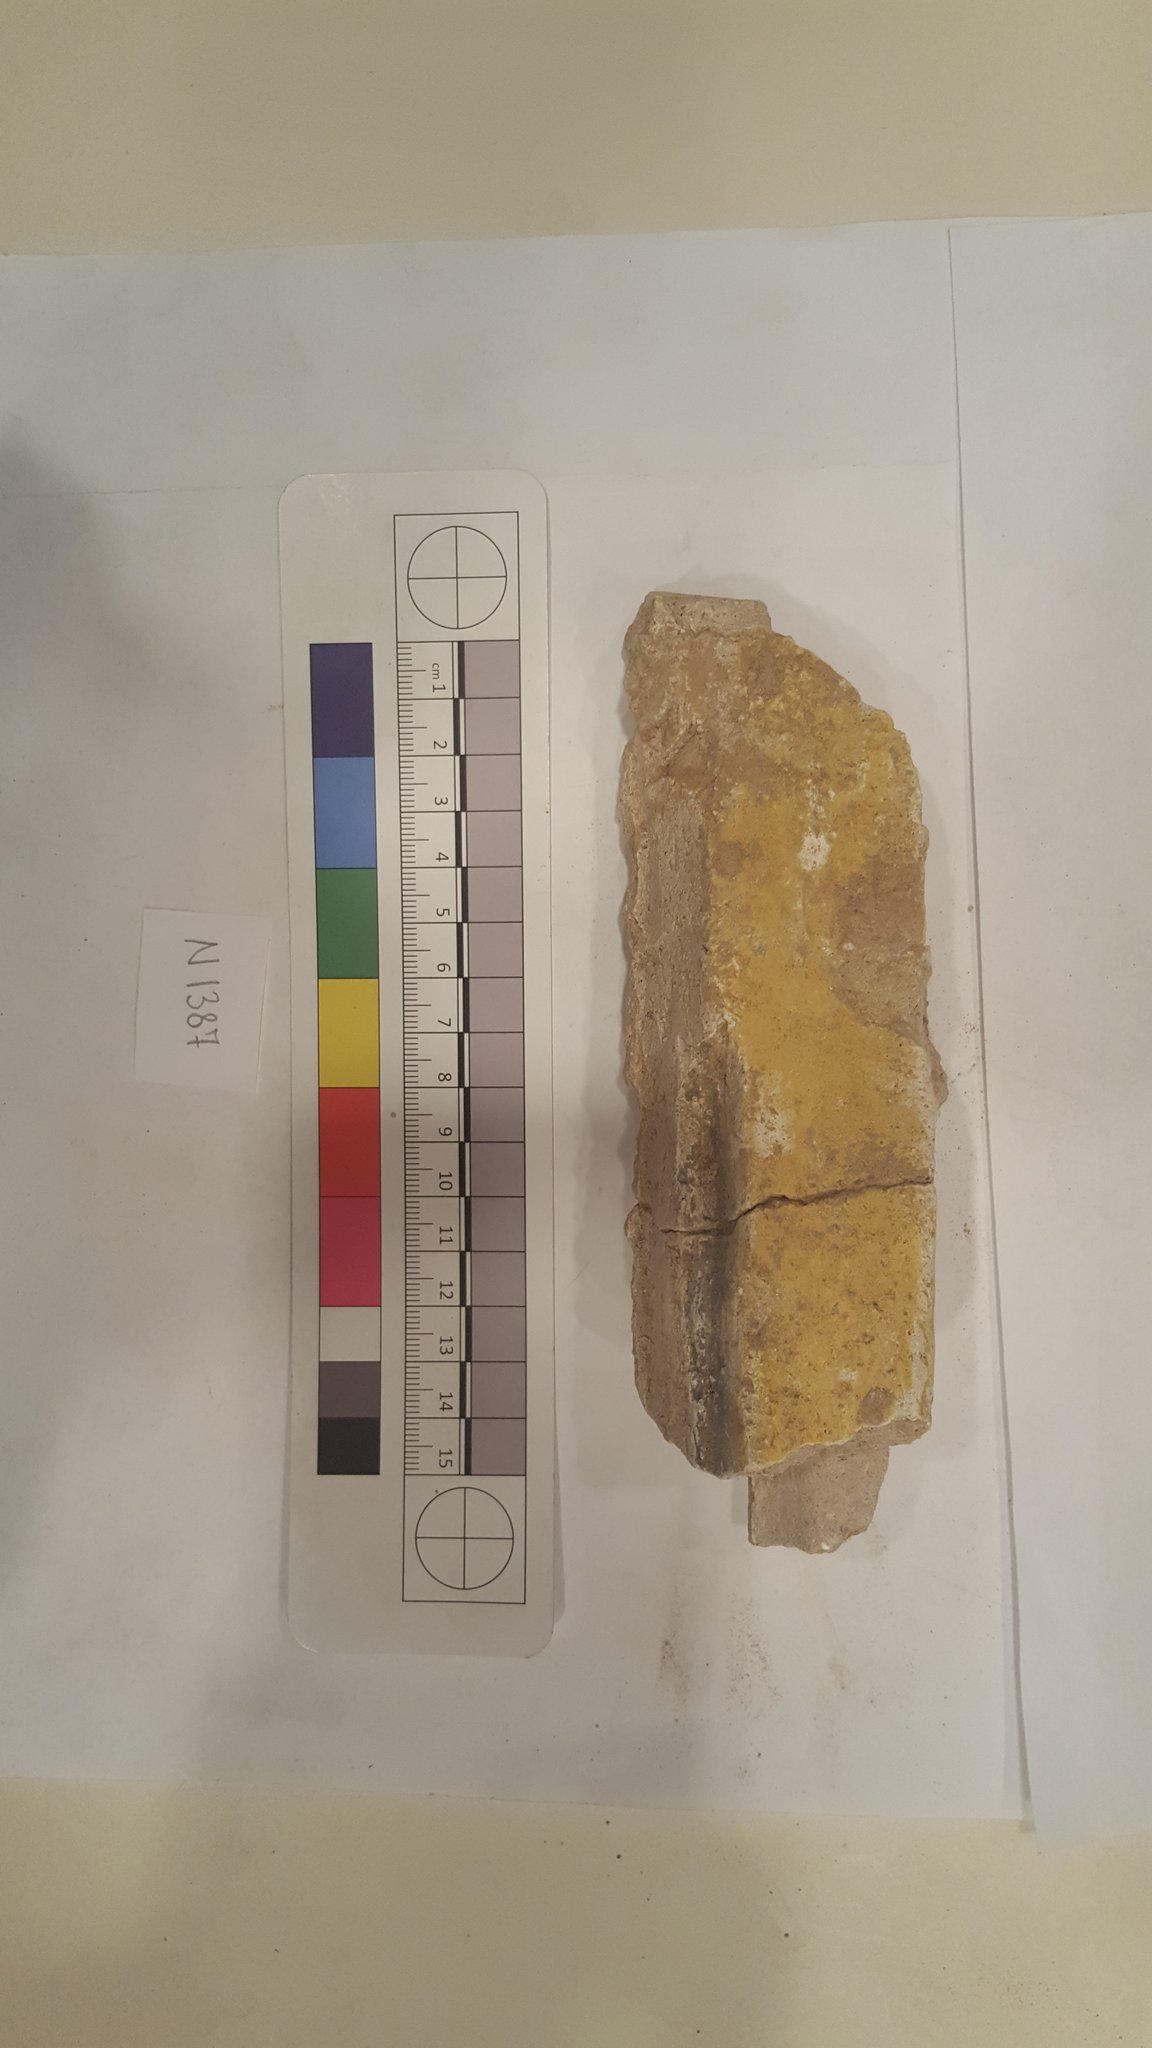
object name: fragment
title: Stucco Fragment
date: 701-1200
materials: plaster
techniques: carving, painting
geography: iran